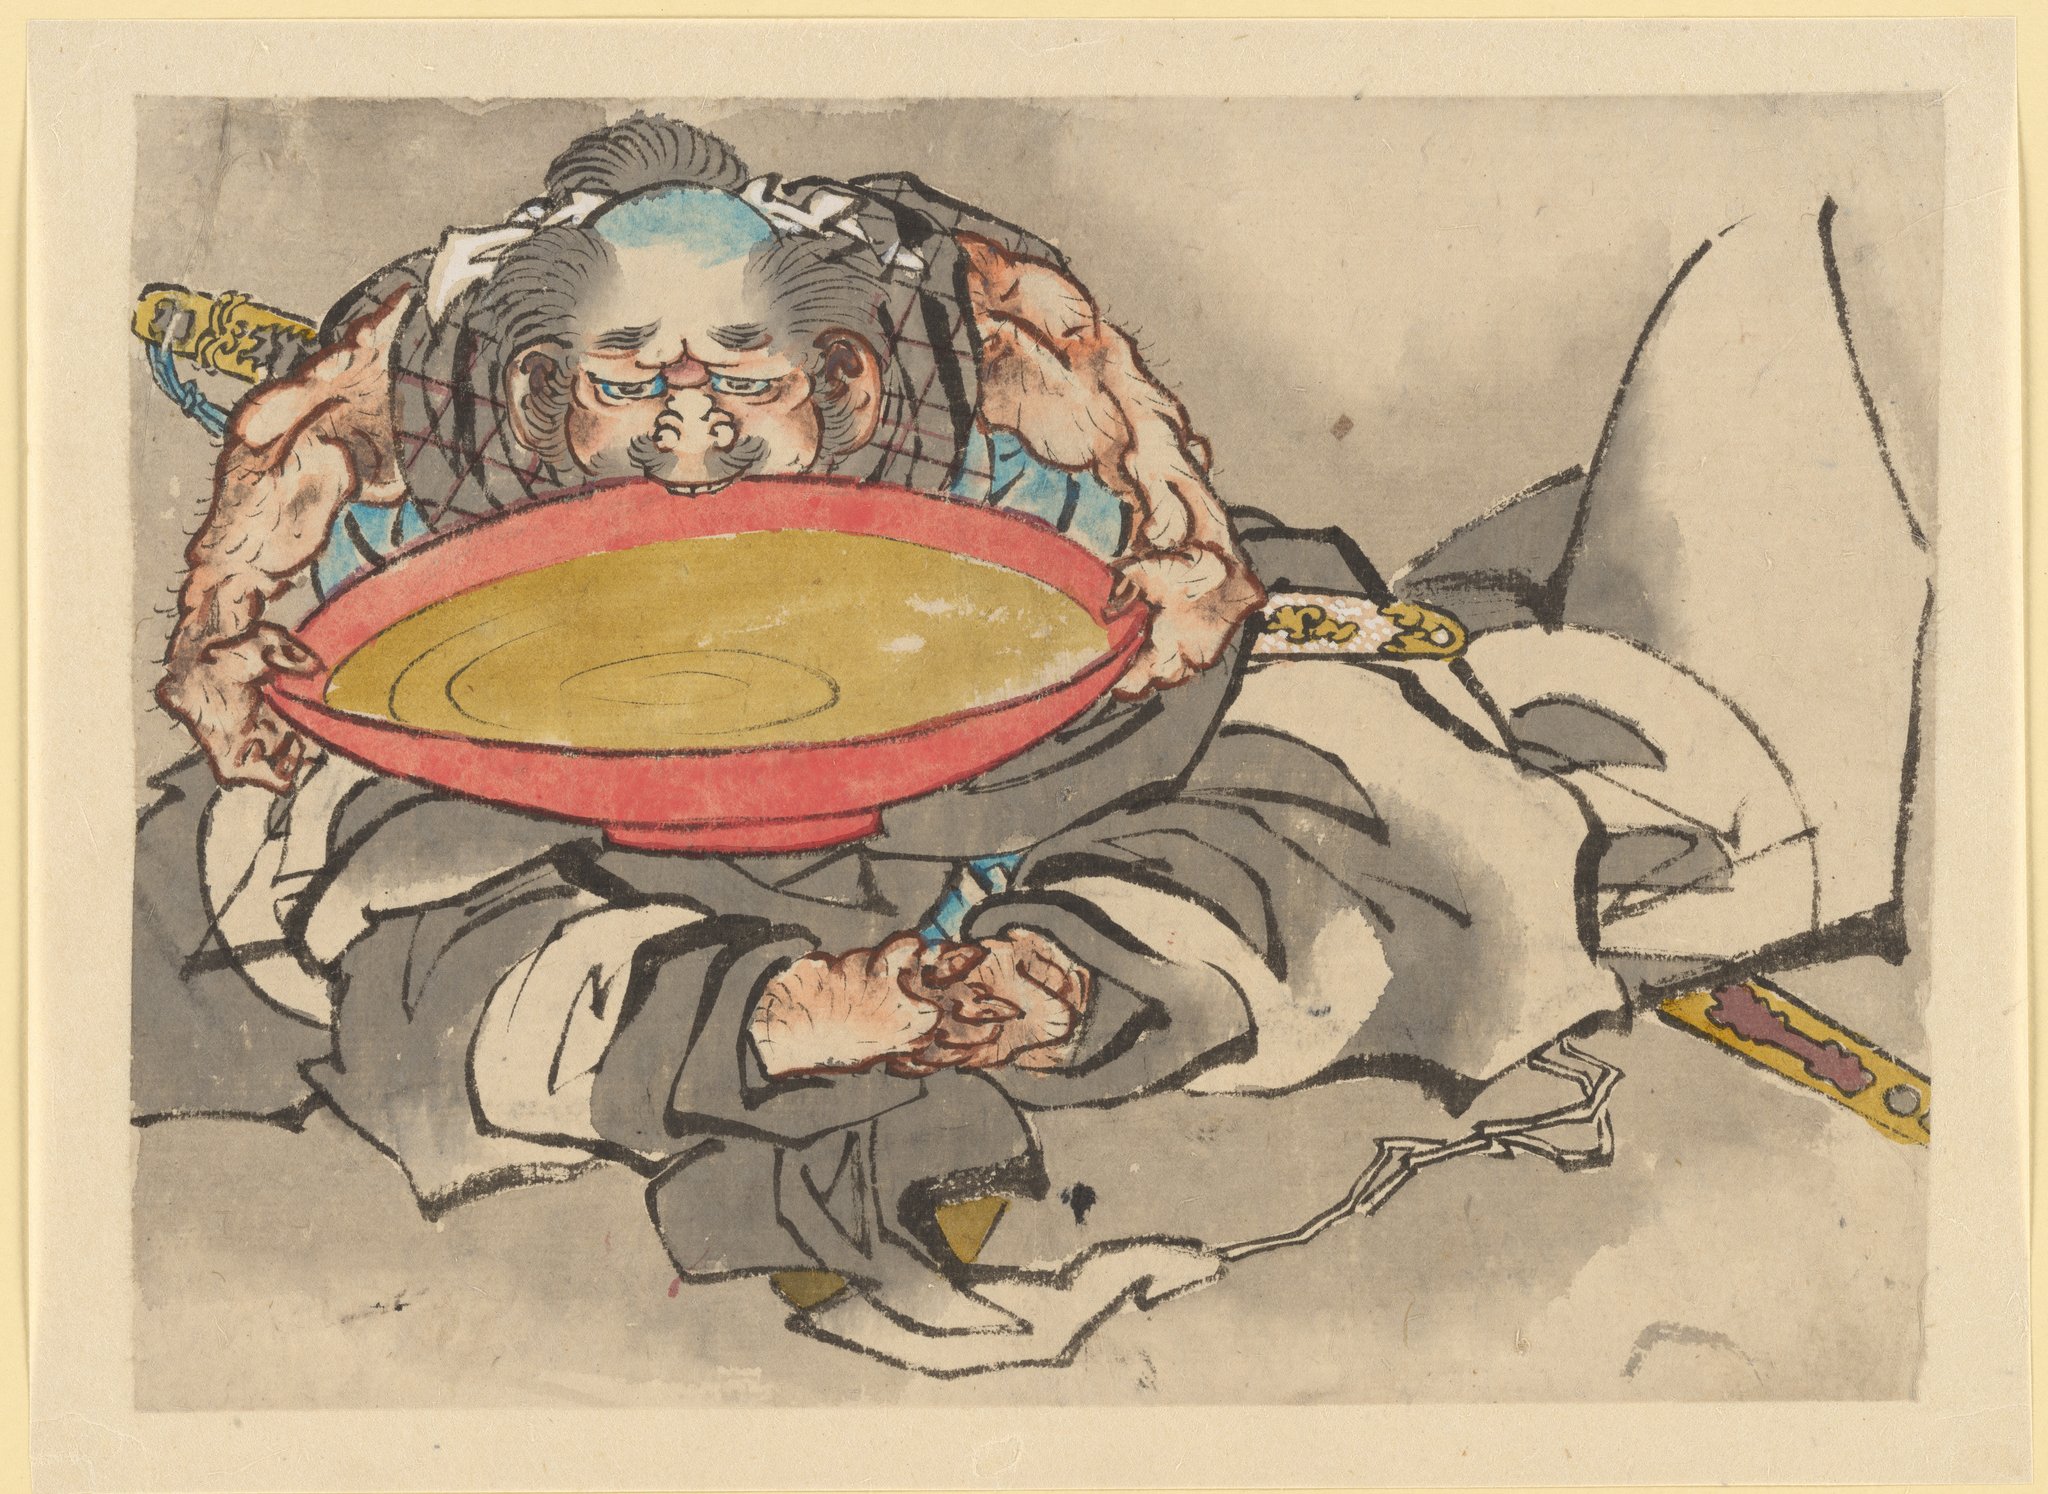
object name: drawing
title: Sakata Kintoki Drinking Sake Wine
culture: japanese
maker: katsushika hokusai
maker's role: artist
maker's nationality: japanese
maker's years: 1760-1849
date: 1701-1900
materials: ink, paper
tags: wine,men,drinking